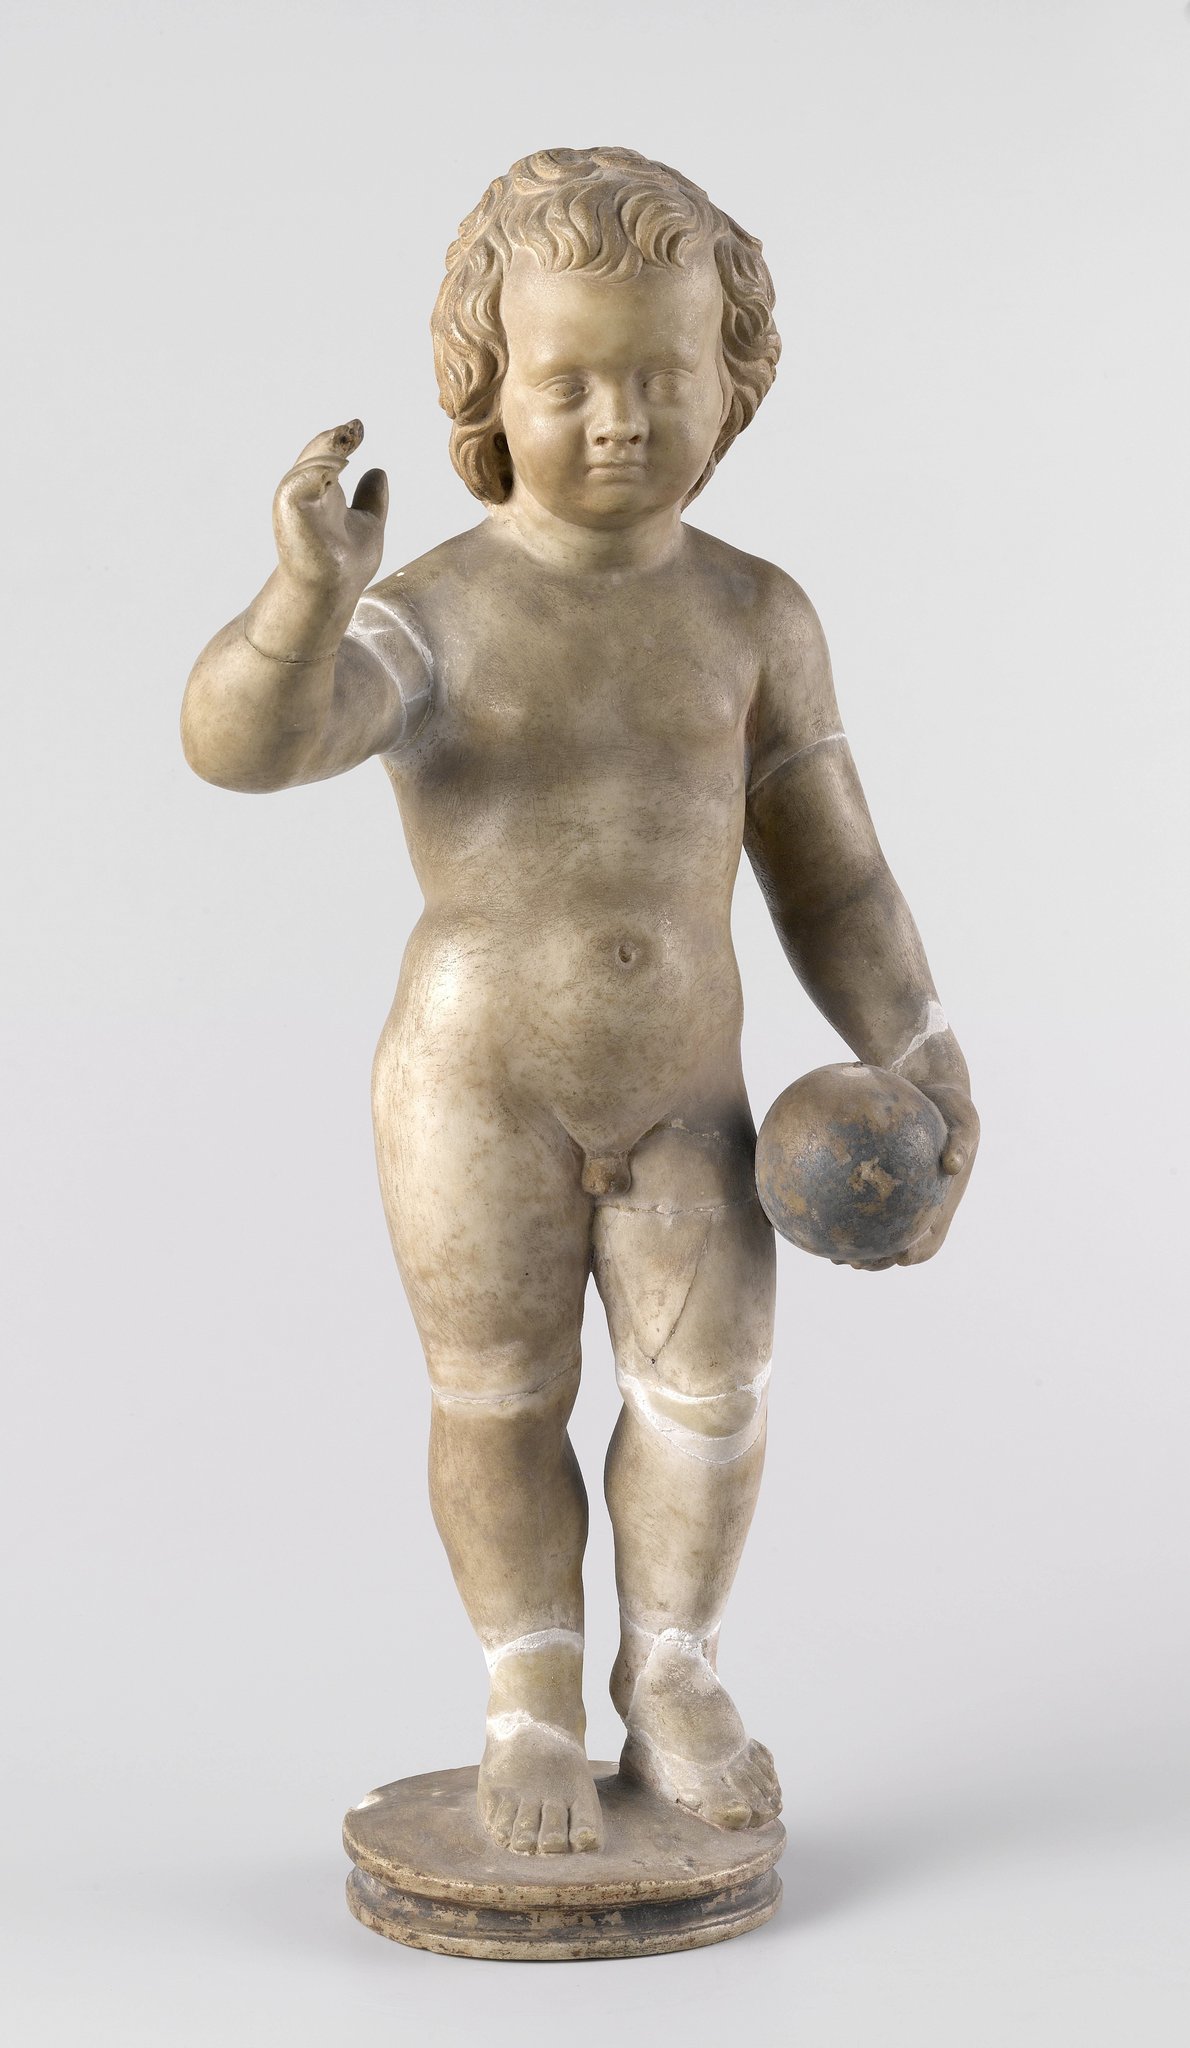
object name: sculpture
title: Zegenend Christuskind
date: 1525-1575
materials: marble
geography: italy